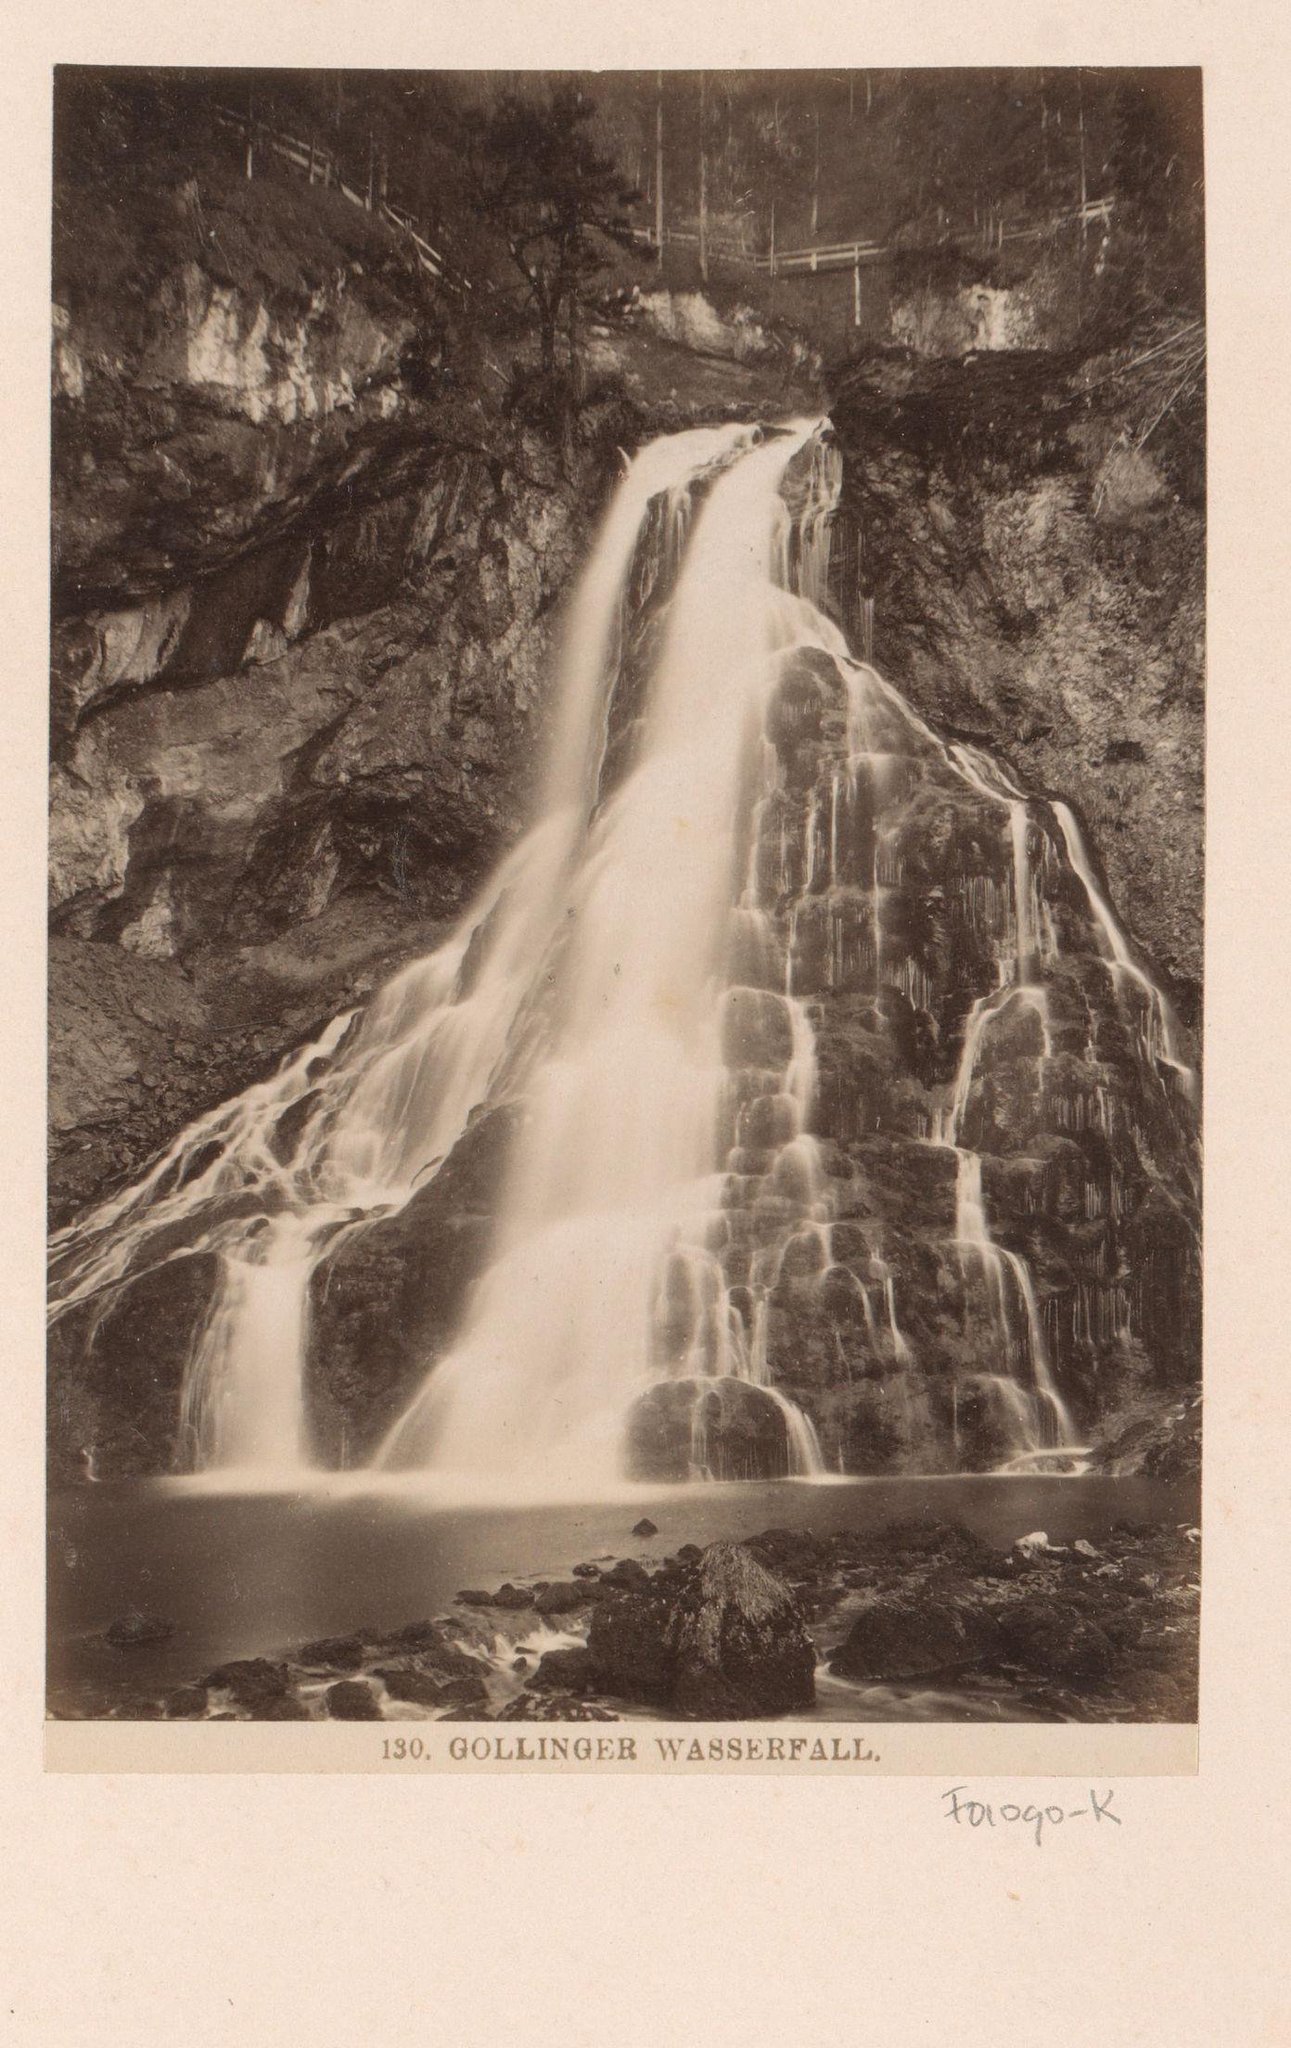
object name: photograph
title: Gezicht op de Gollinger waterval (Schwarzbachfall) in Oostenrijk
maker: Anonymous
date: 1870-1900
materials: paper, photographic support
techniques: albumen print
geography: austria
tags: waterfall, austria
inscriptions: negative number: ‘130’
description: Onderdeel van Reisalbum met foto's van bezienswaardigheden in Duitsland en Oostenrijk en van kunstwerken.